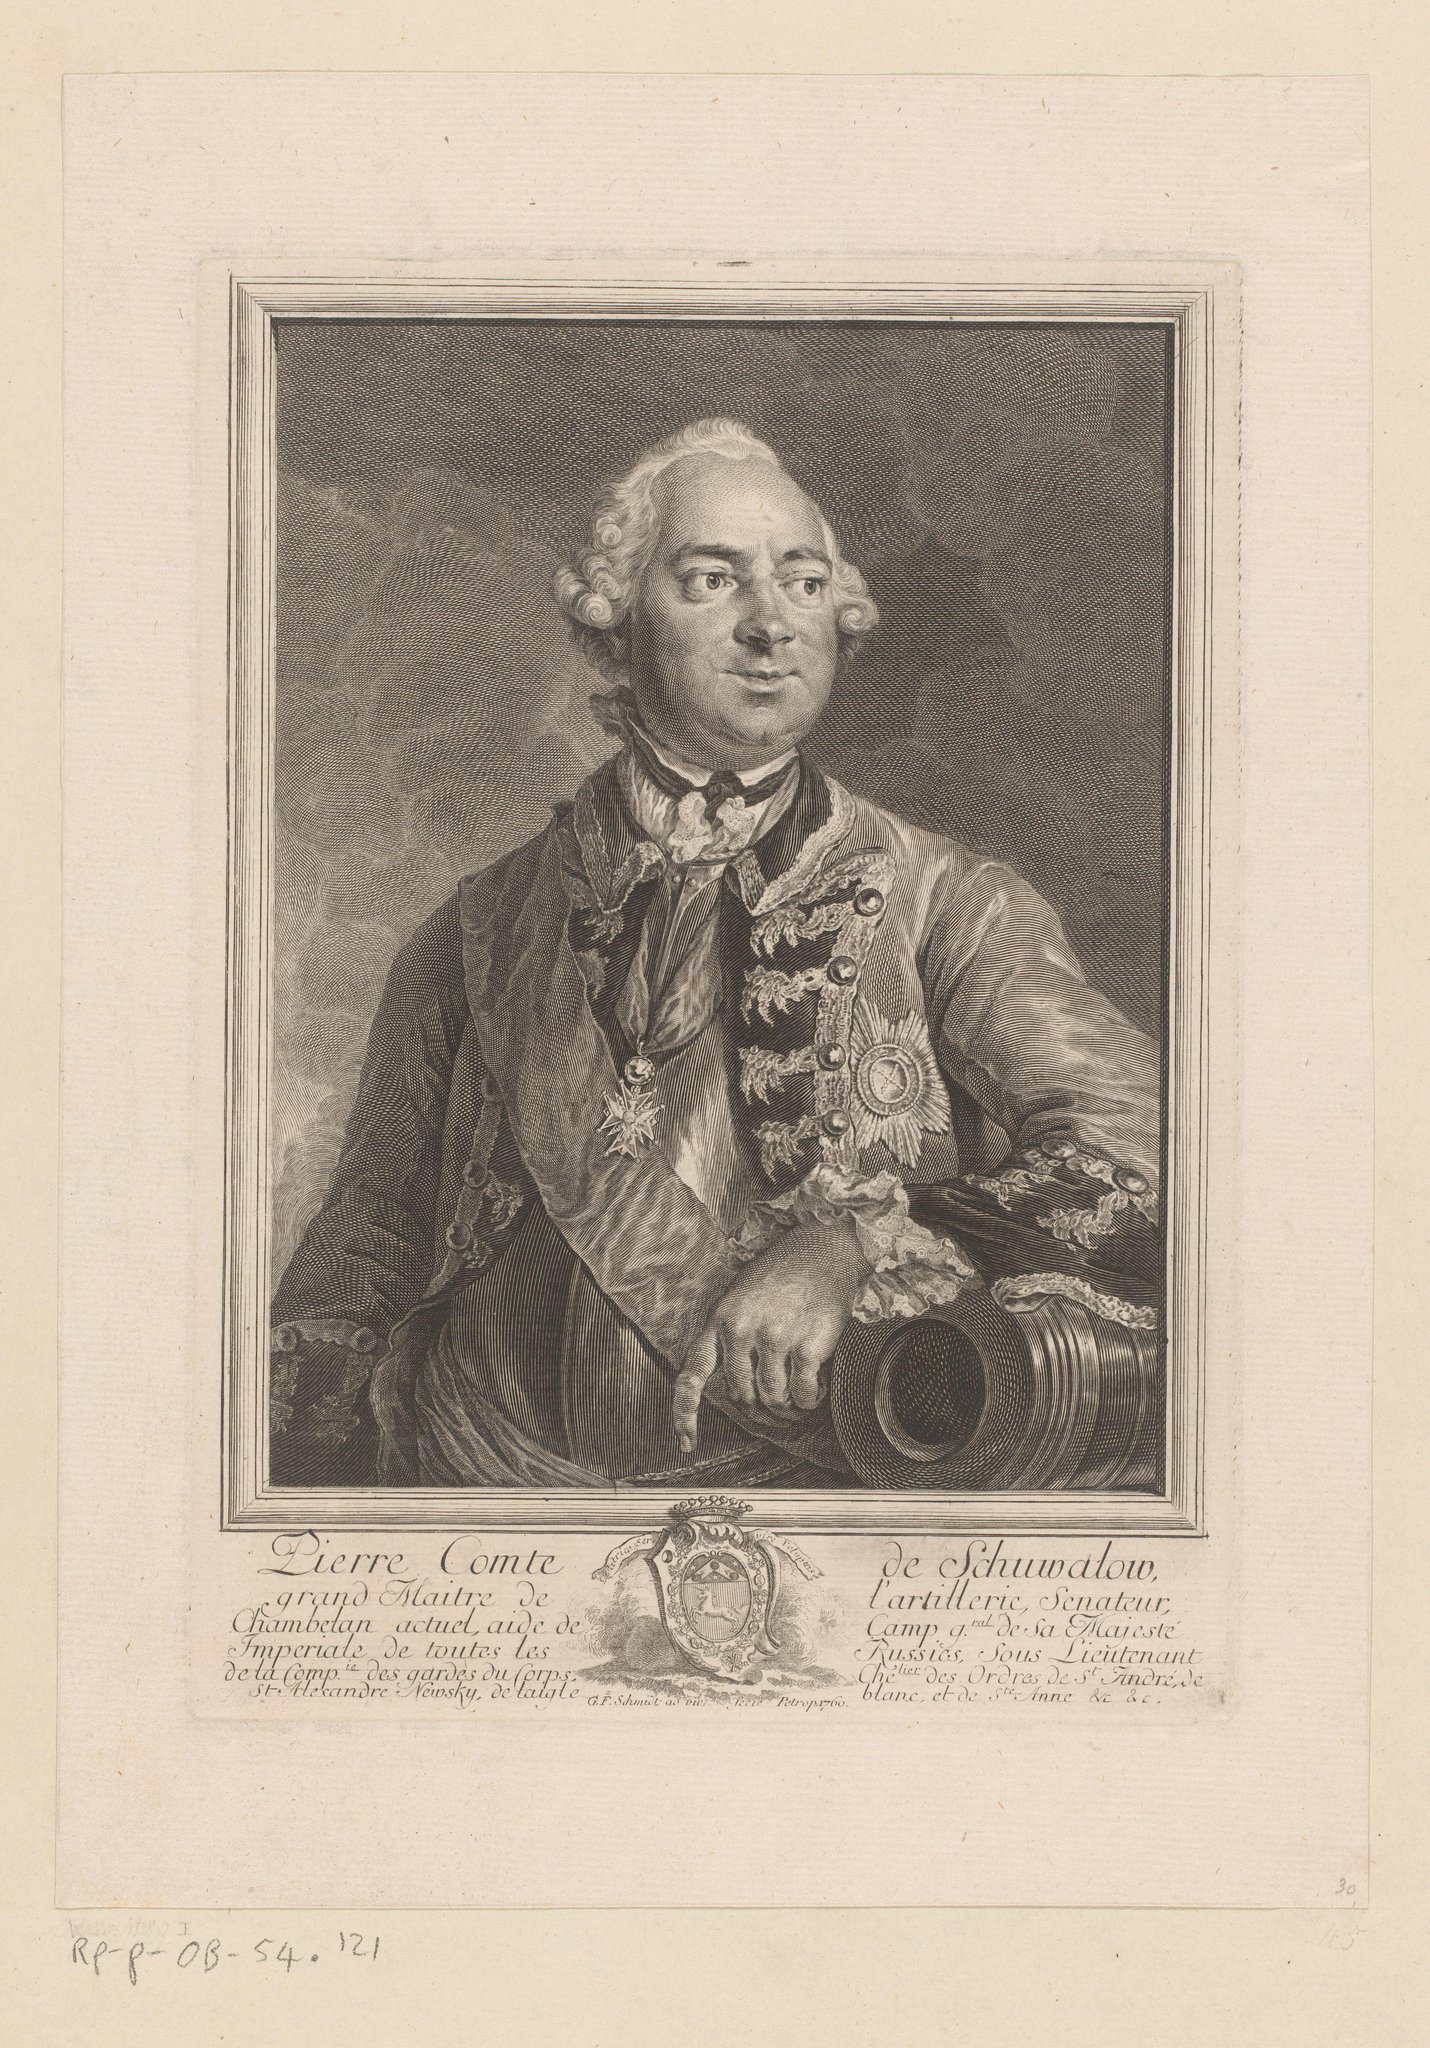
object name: print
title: Portret van Peter Ivanovich Shuvalow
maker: georg friedrich schmidt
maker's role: draughtsman, print maker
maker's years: 1712-1775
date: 1760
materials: paper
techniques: engraving, etching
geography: sint-petersburg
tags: historical persons, armorial bearing, heraldry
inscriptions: collector's mark: Lugt 240